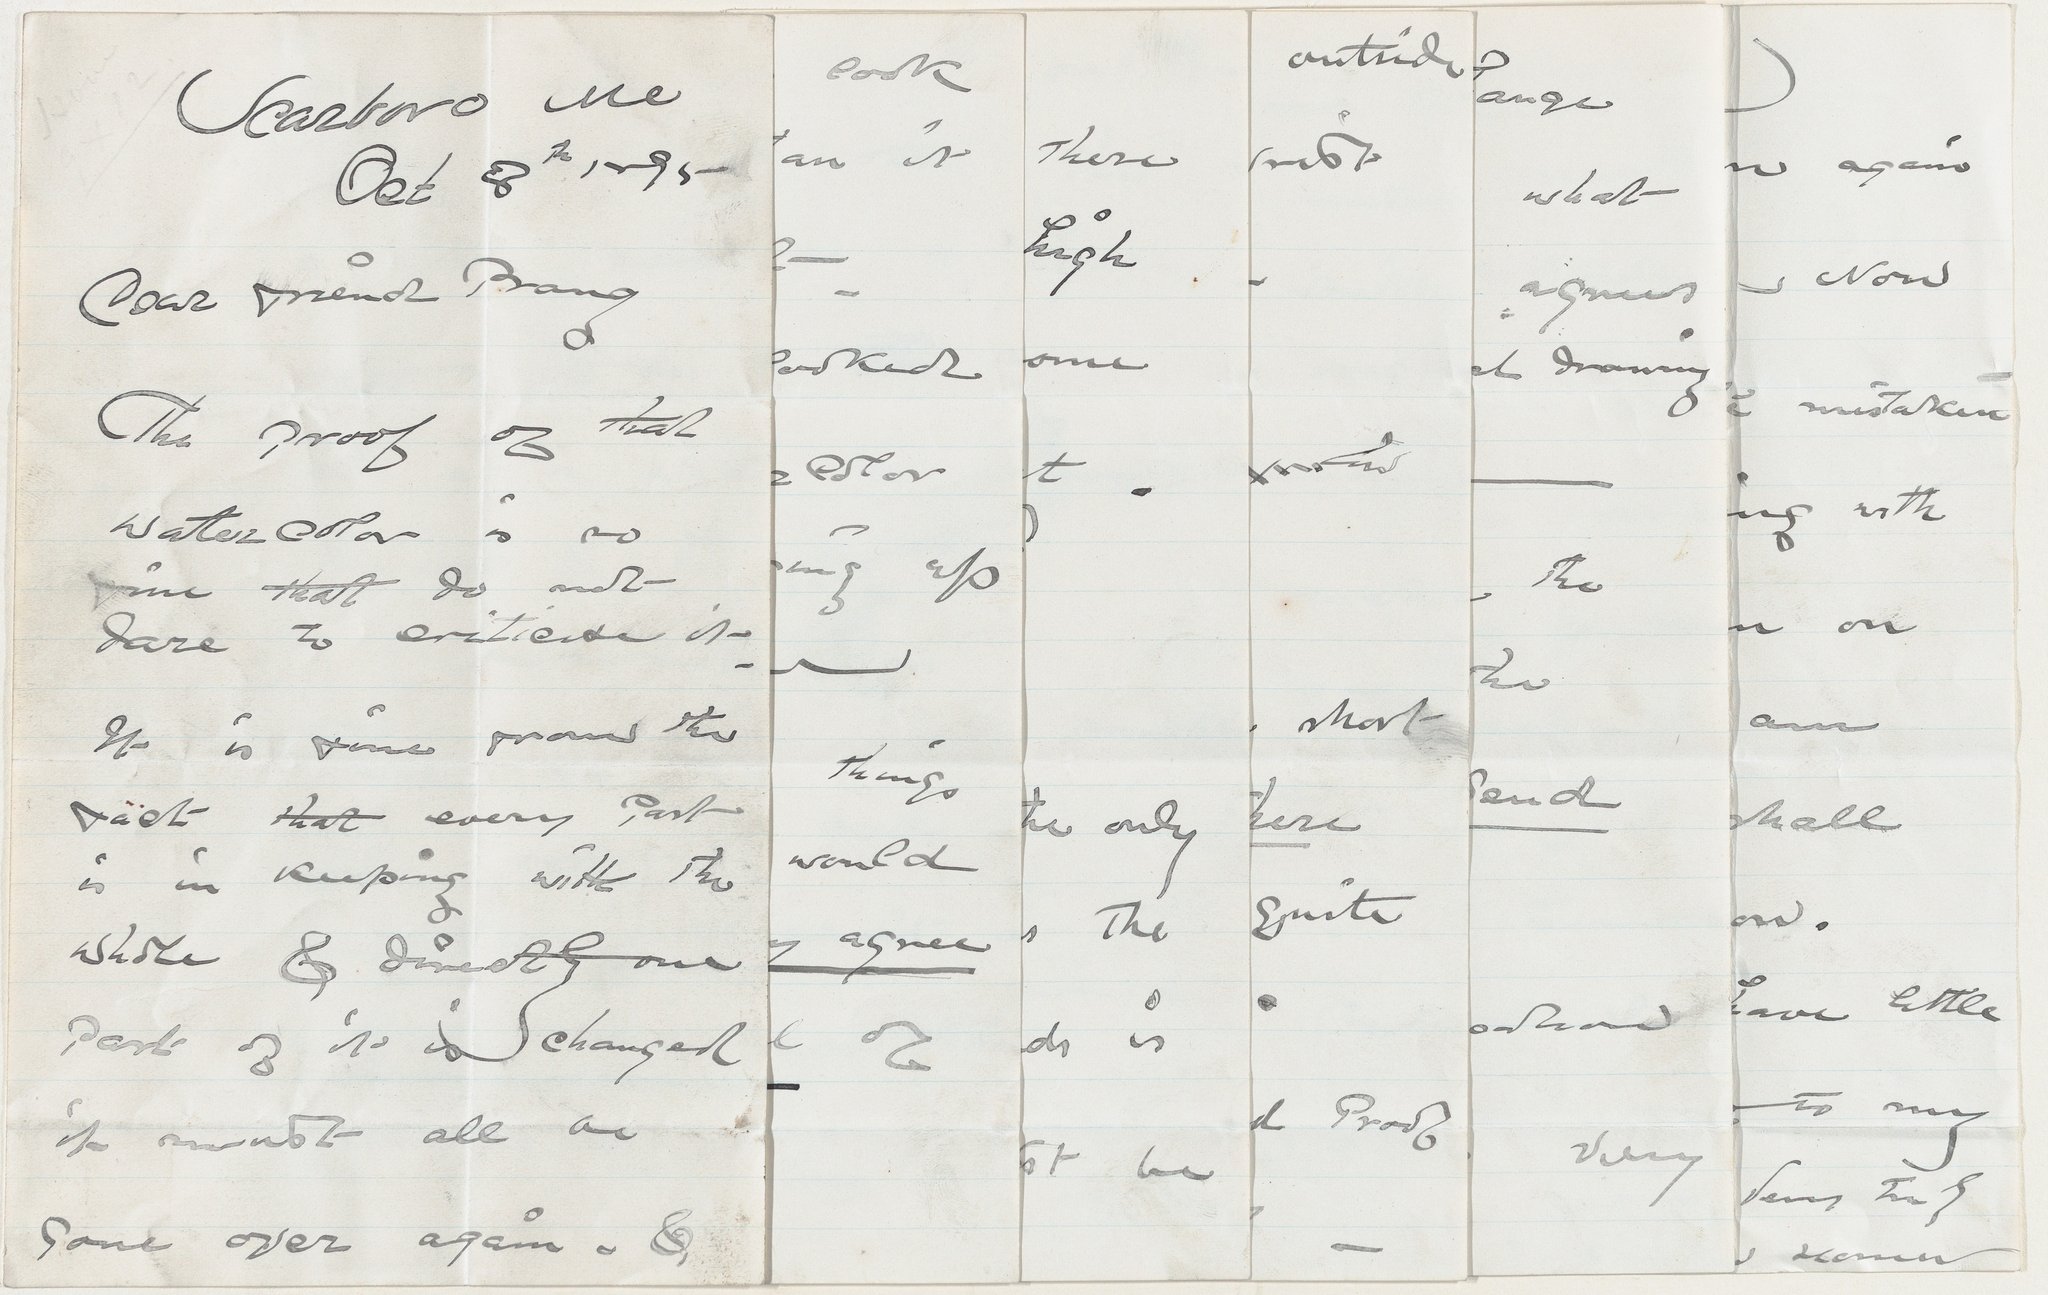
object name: letter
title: Autograph Letter to Louis Prang, Discussing lithograph of "The Eastern Shore"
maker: winslow homer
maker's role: author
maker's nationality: american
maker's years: 1836-1910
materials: graphite, ink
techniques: pen